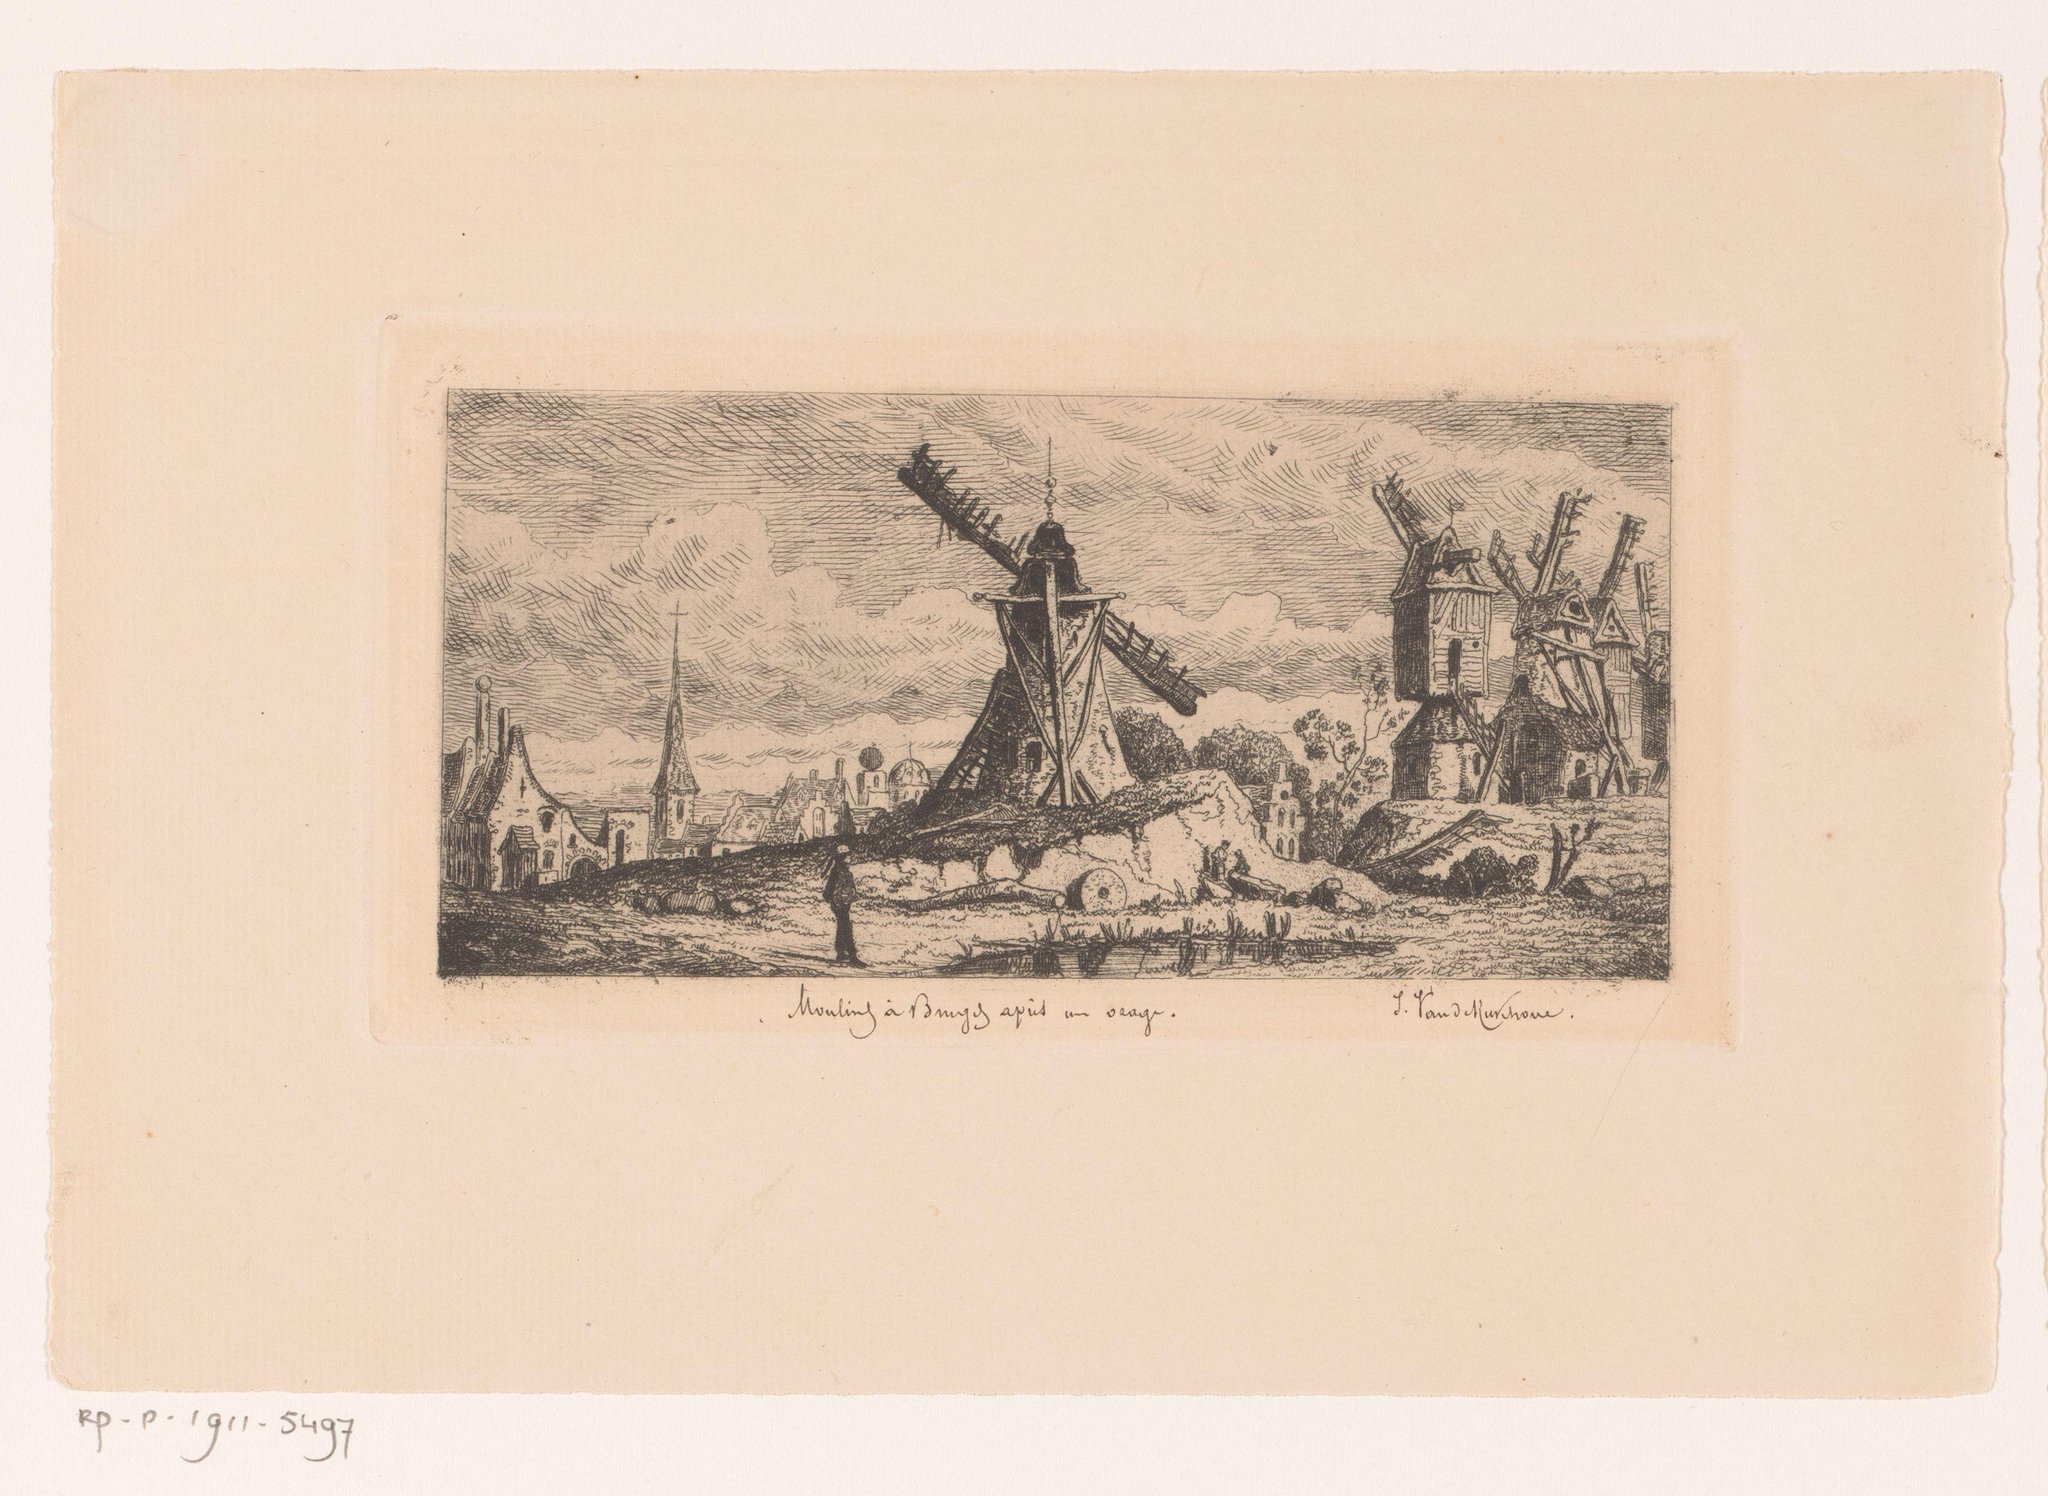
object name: print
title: Moulins à Bruges après un orage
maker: jan van de kerkhove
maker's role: print maker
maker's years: 1822-1881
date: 1832-1881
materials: paper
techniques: drypoint, etching, intaglio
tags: windmill in landscape, storm on land, bruges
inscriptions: collector's mark: Lugt 2228